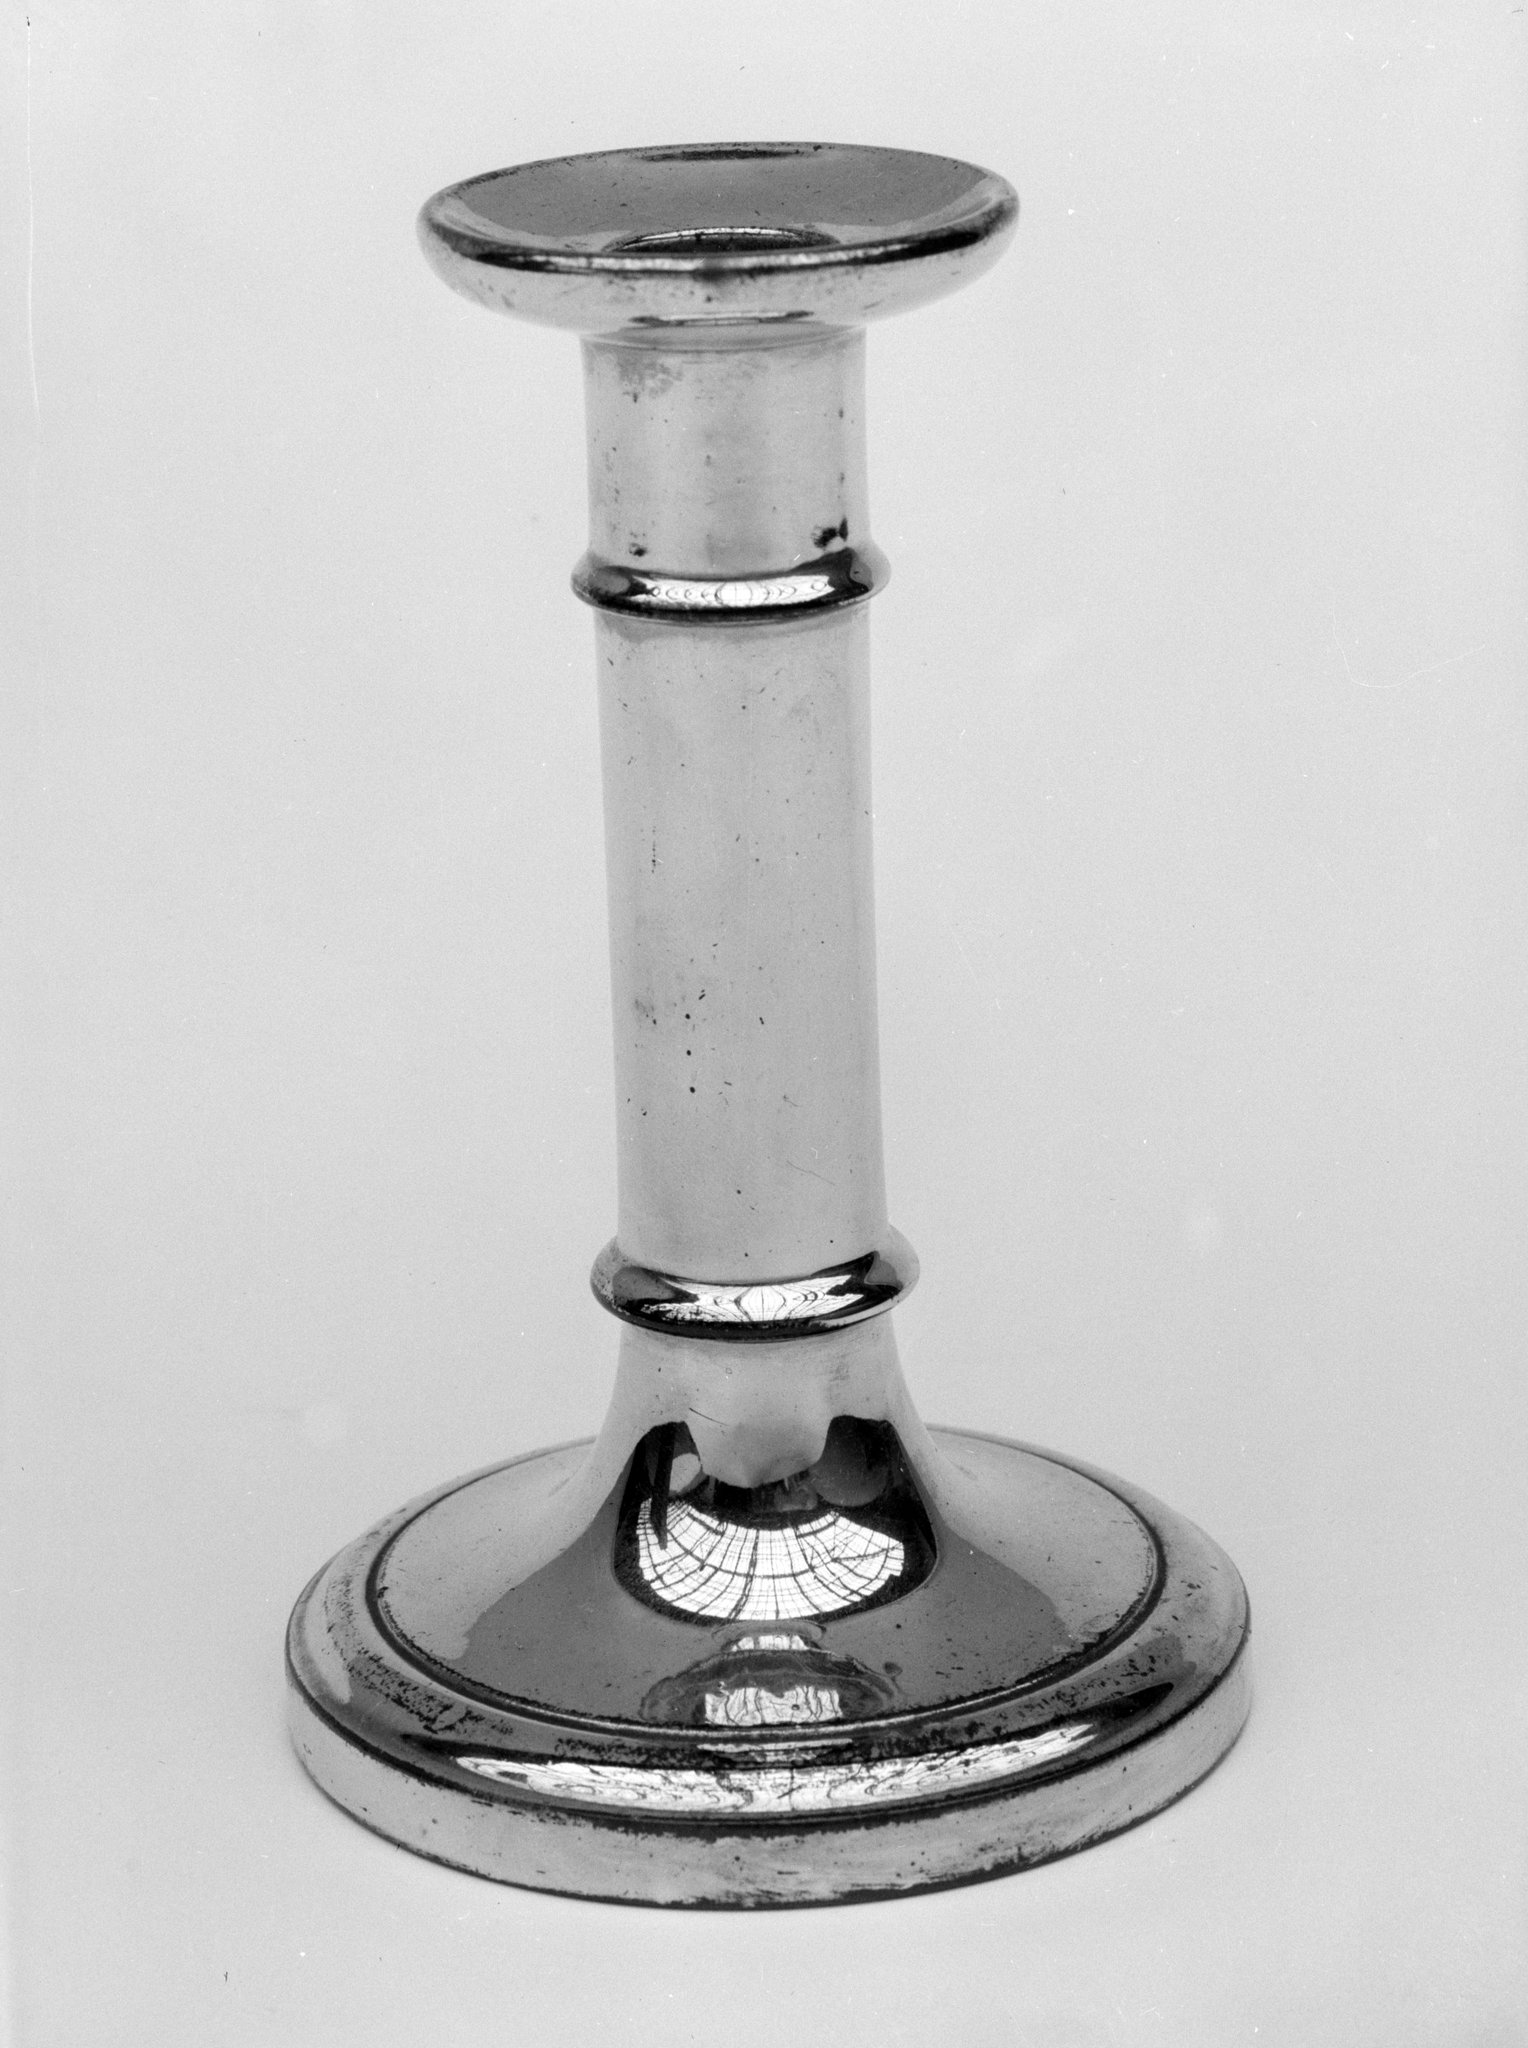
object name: candlestick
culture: british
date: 1800-1830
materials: earthenware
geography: england